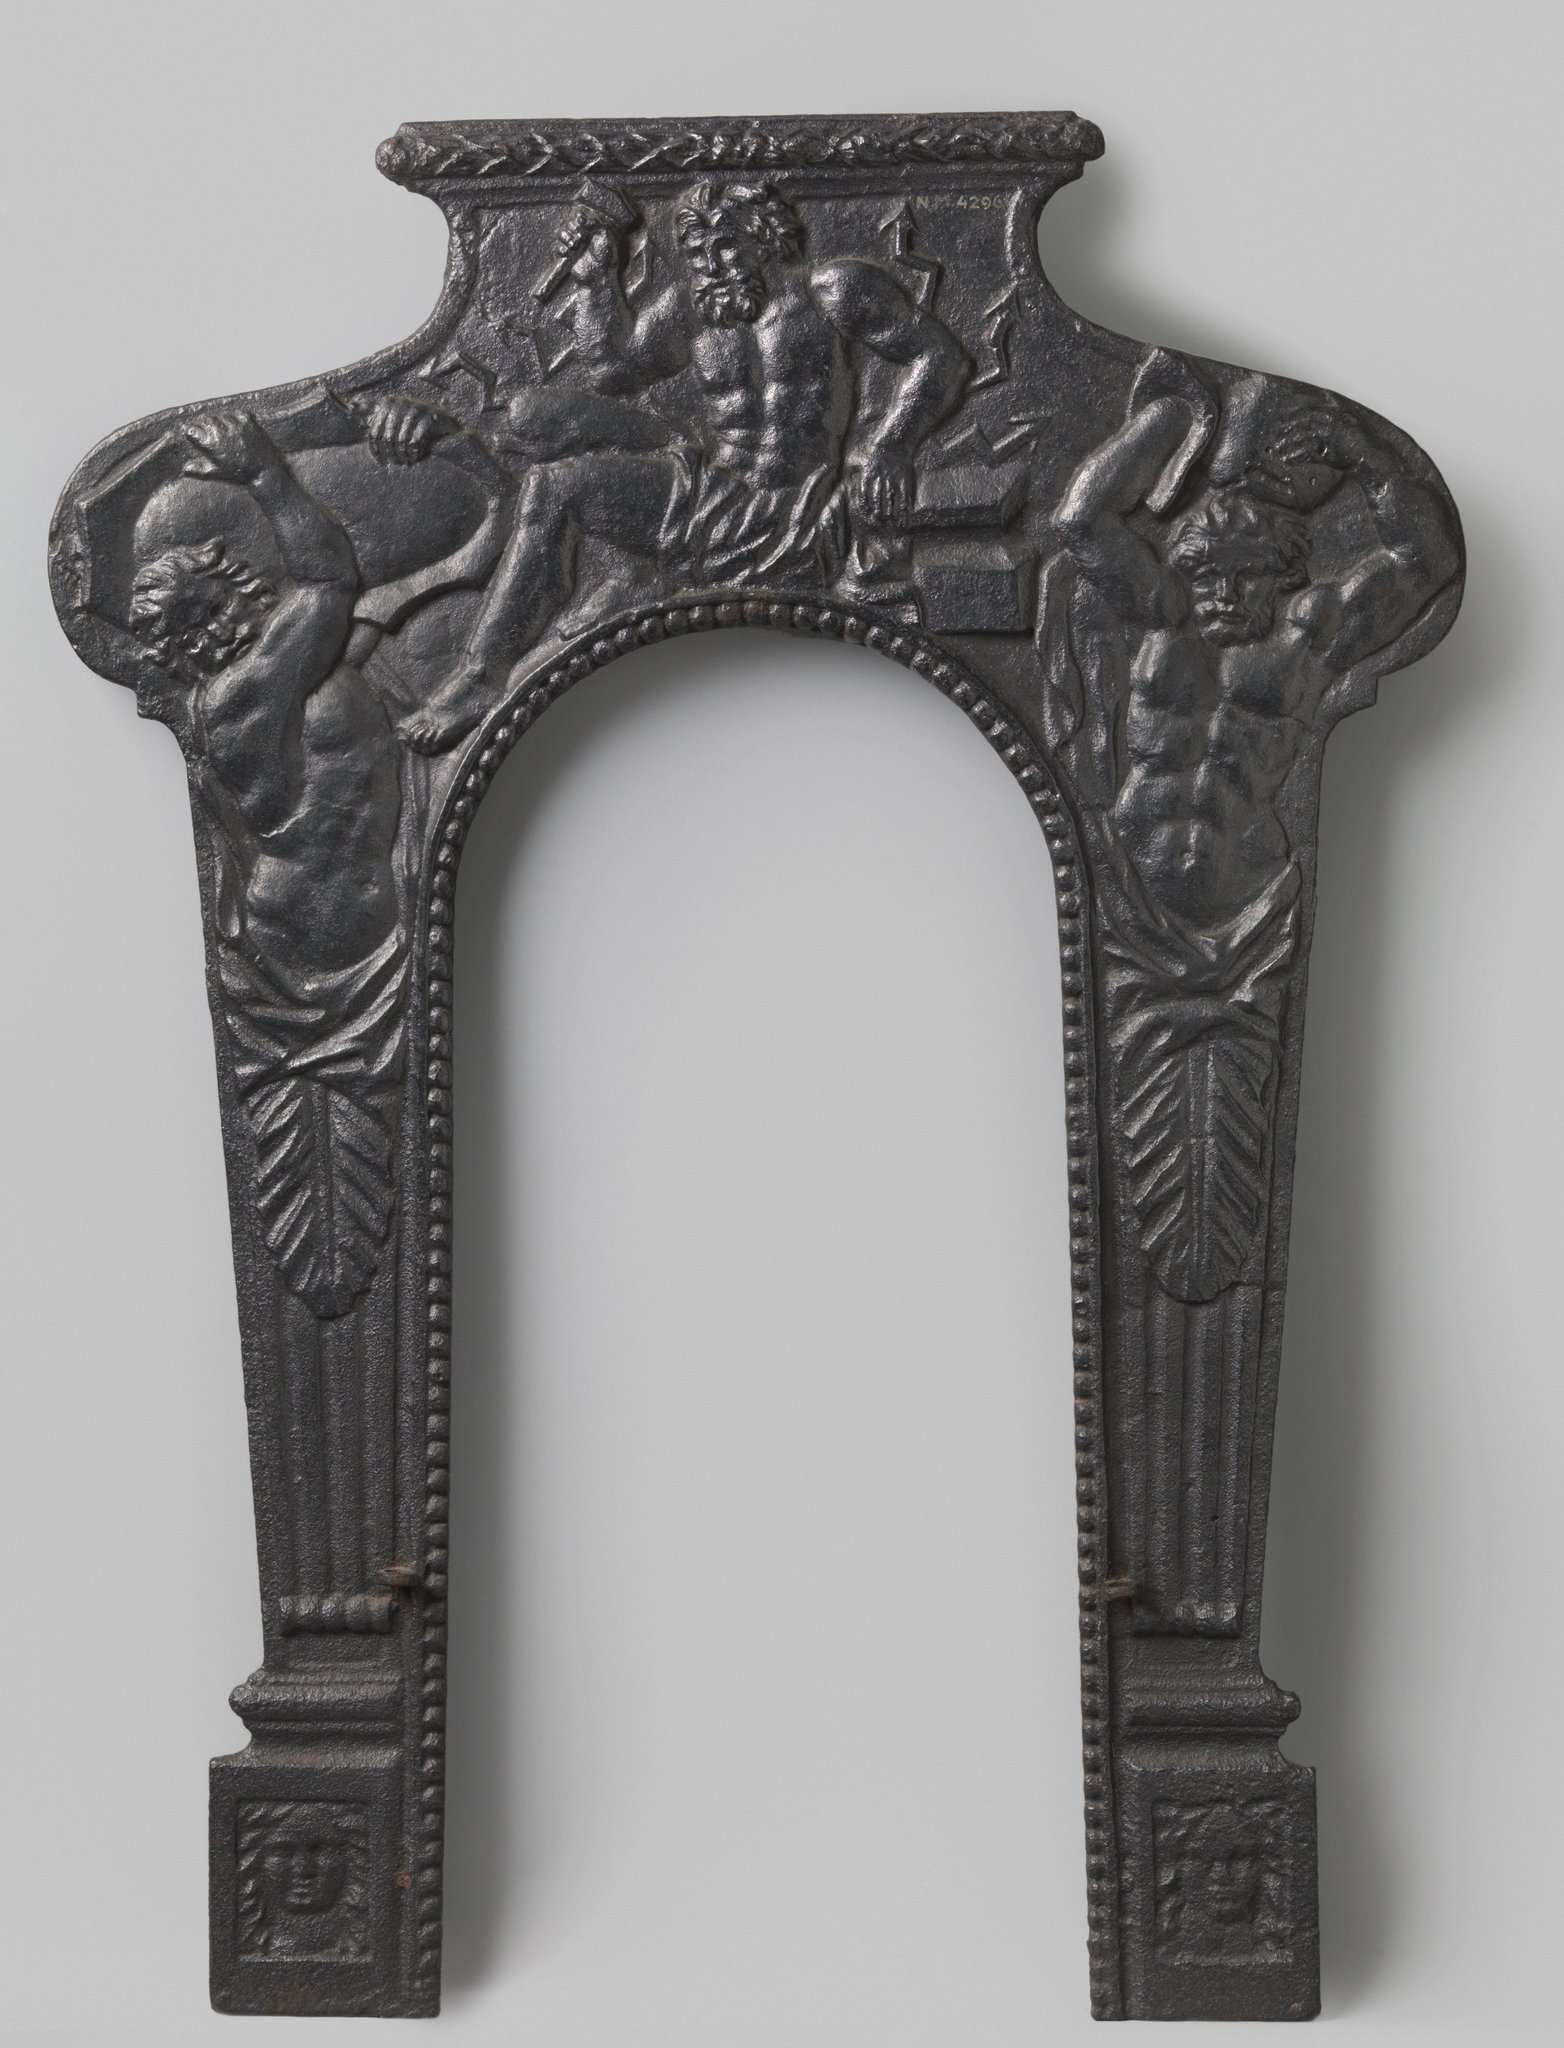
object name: haardombouw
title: Gietijzeren plaat voor ombouw van de haard, met Vulcanus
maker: Anonymous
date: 1650-1700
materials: iron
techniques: casting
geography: germany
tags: (story of) vulcan (hephaestus)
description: Plaat van gietijzer, onderdeel van de haardombouw. De opening wordt omrandt met een eierlijst. De pilasters zijn versierd met onderaan een kopje in een vierkante omlijsting, daarboven ribben en een bladmotief, waarboven aan weerszijden een mannenbuste die iets zwaars tilt. Daartussen is Vulcanus gezeten met hamer en bliksemschichten, als bekroning.